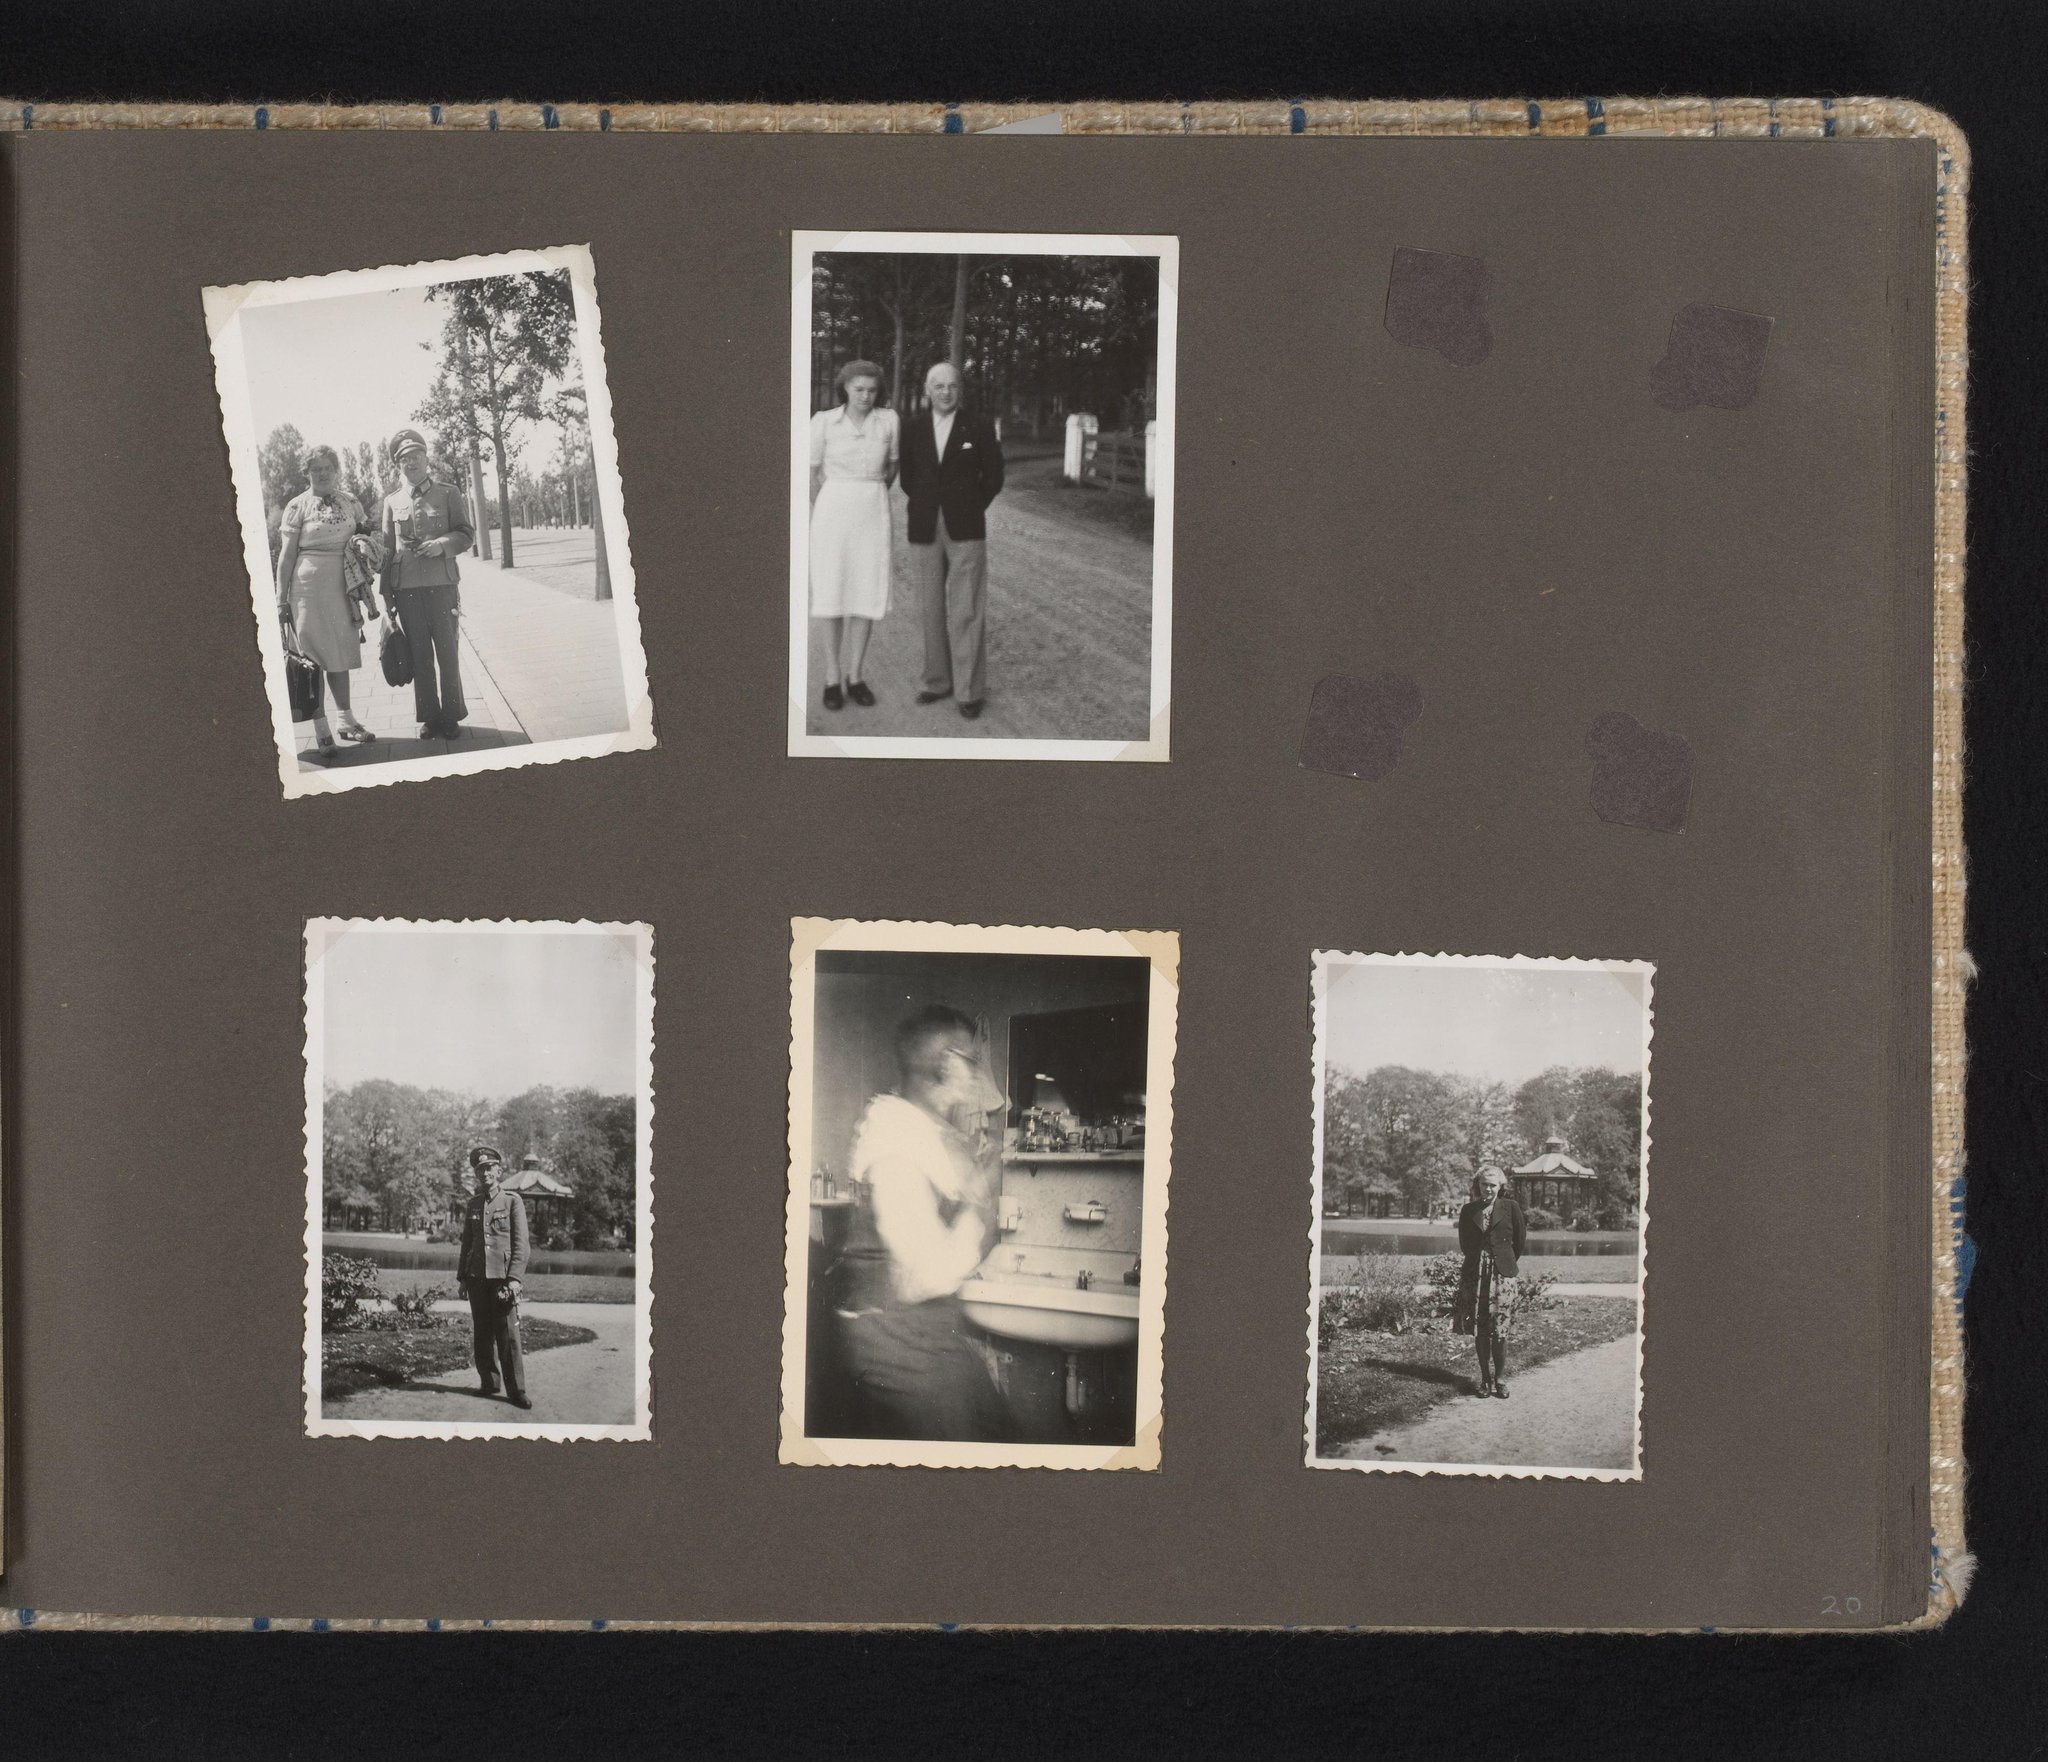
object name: photograph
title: Diverse personen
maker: Anonymous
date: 1941-1942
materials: cardboard, photographic support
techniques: gelatin silver print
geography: netherlands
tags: the soldier off duty, occupation ~ war, wood and park (as places of recreation), netherlands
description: Albumblad met vijf foto's van Duitse militairen, familie en vrienden. Onderdeel van het fotoalbum Abrechnungsintendantur van de Wehrmacht 1941-1943.